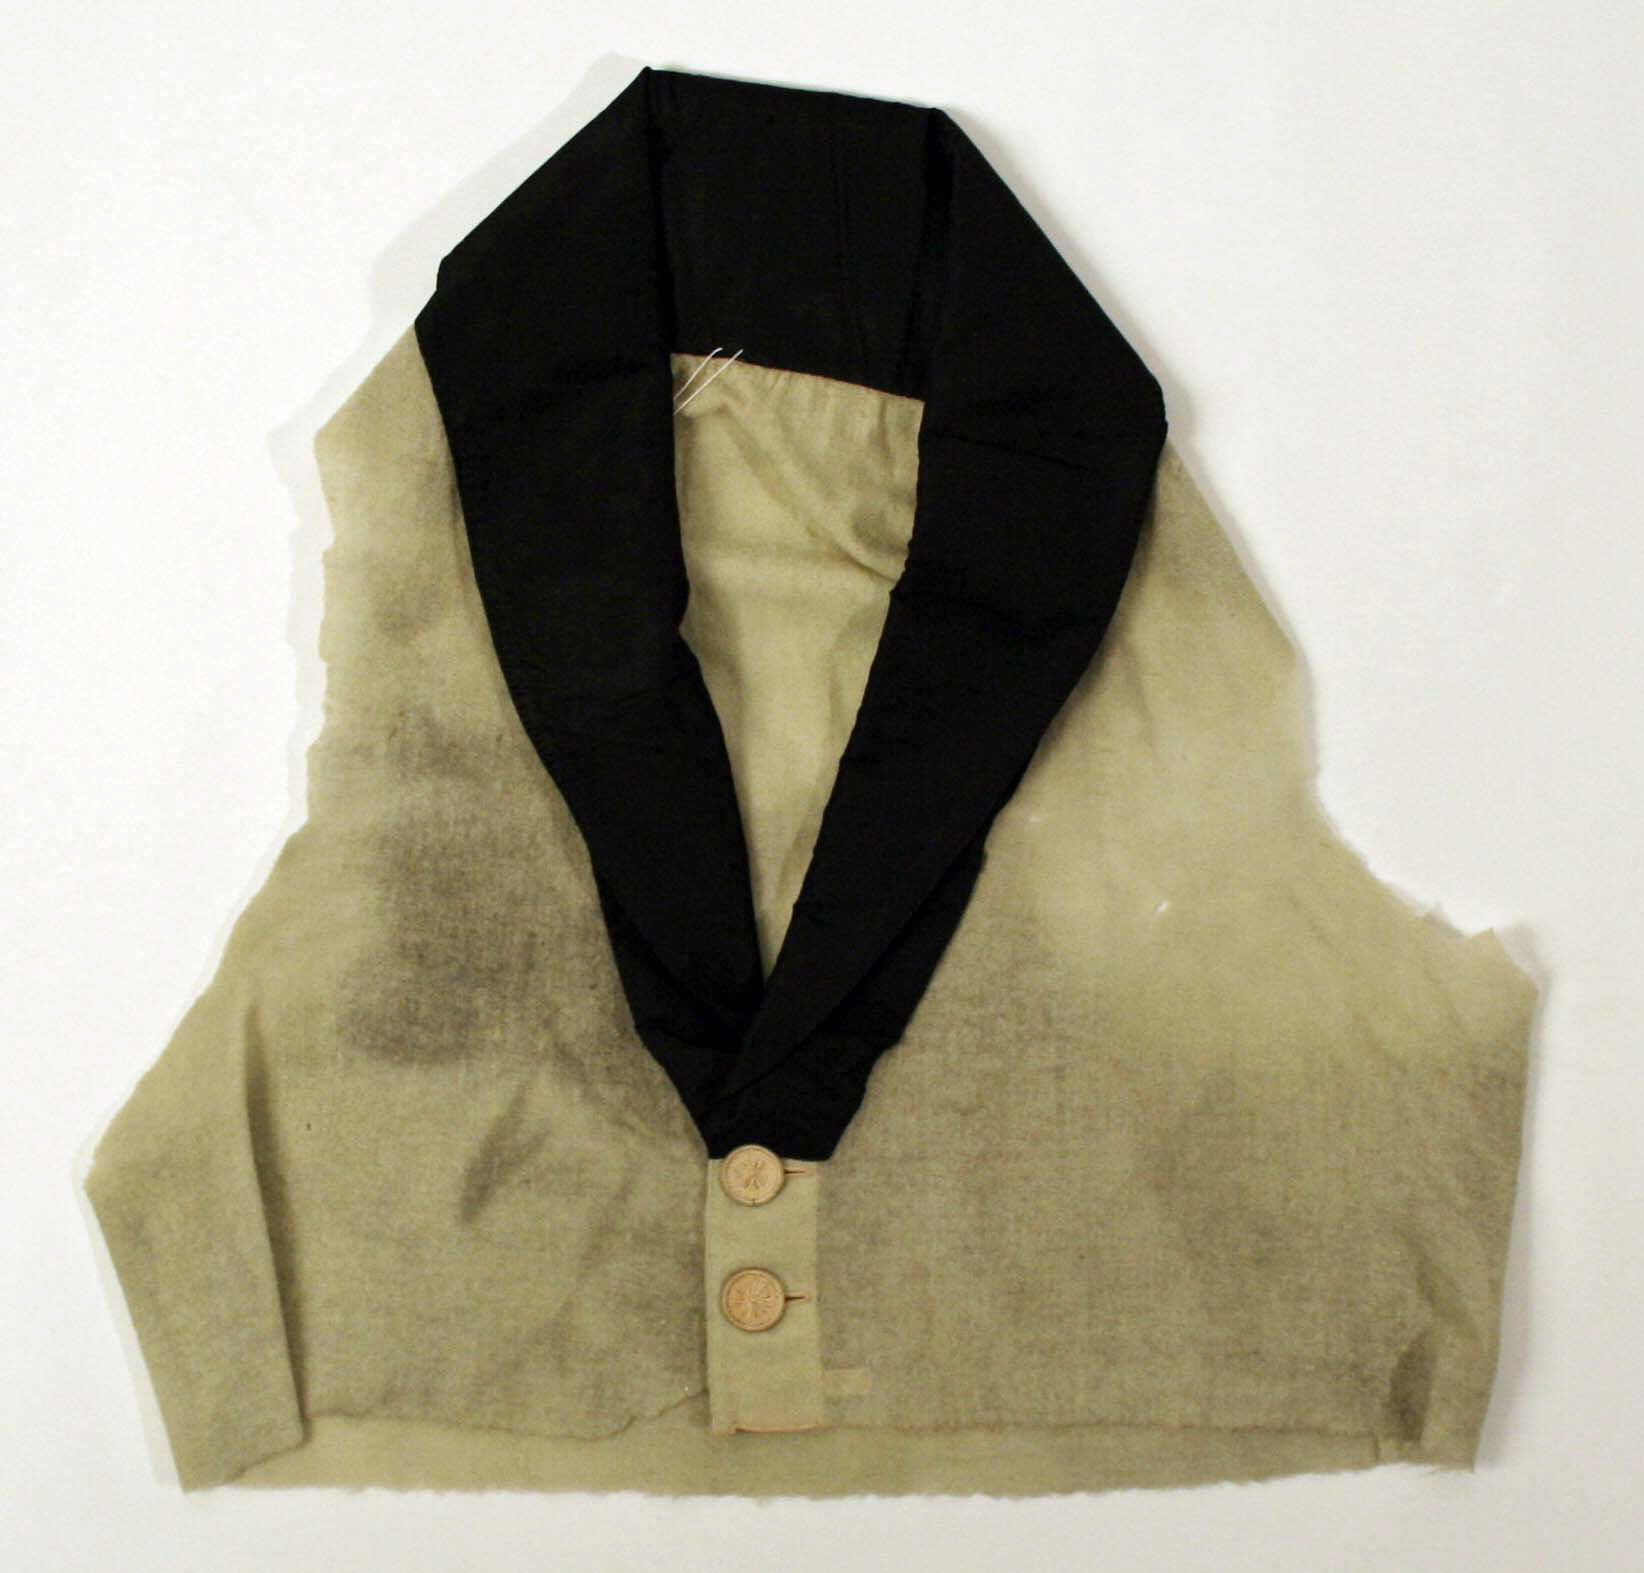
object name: undershirt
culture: british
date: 1810-1820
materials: silk, wool